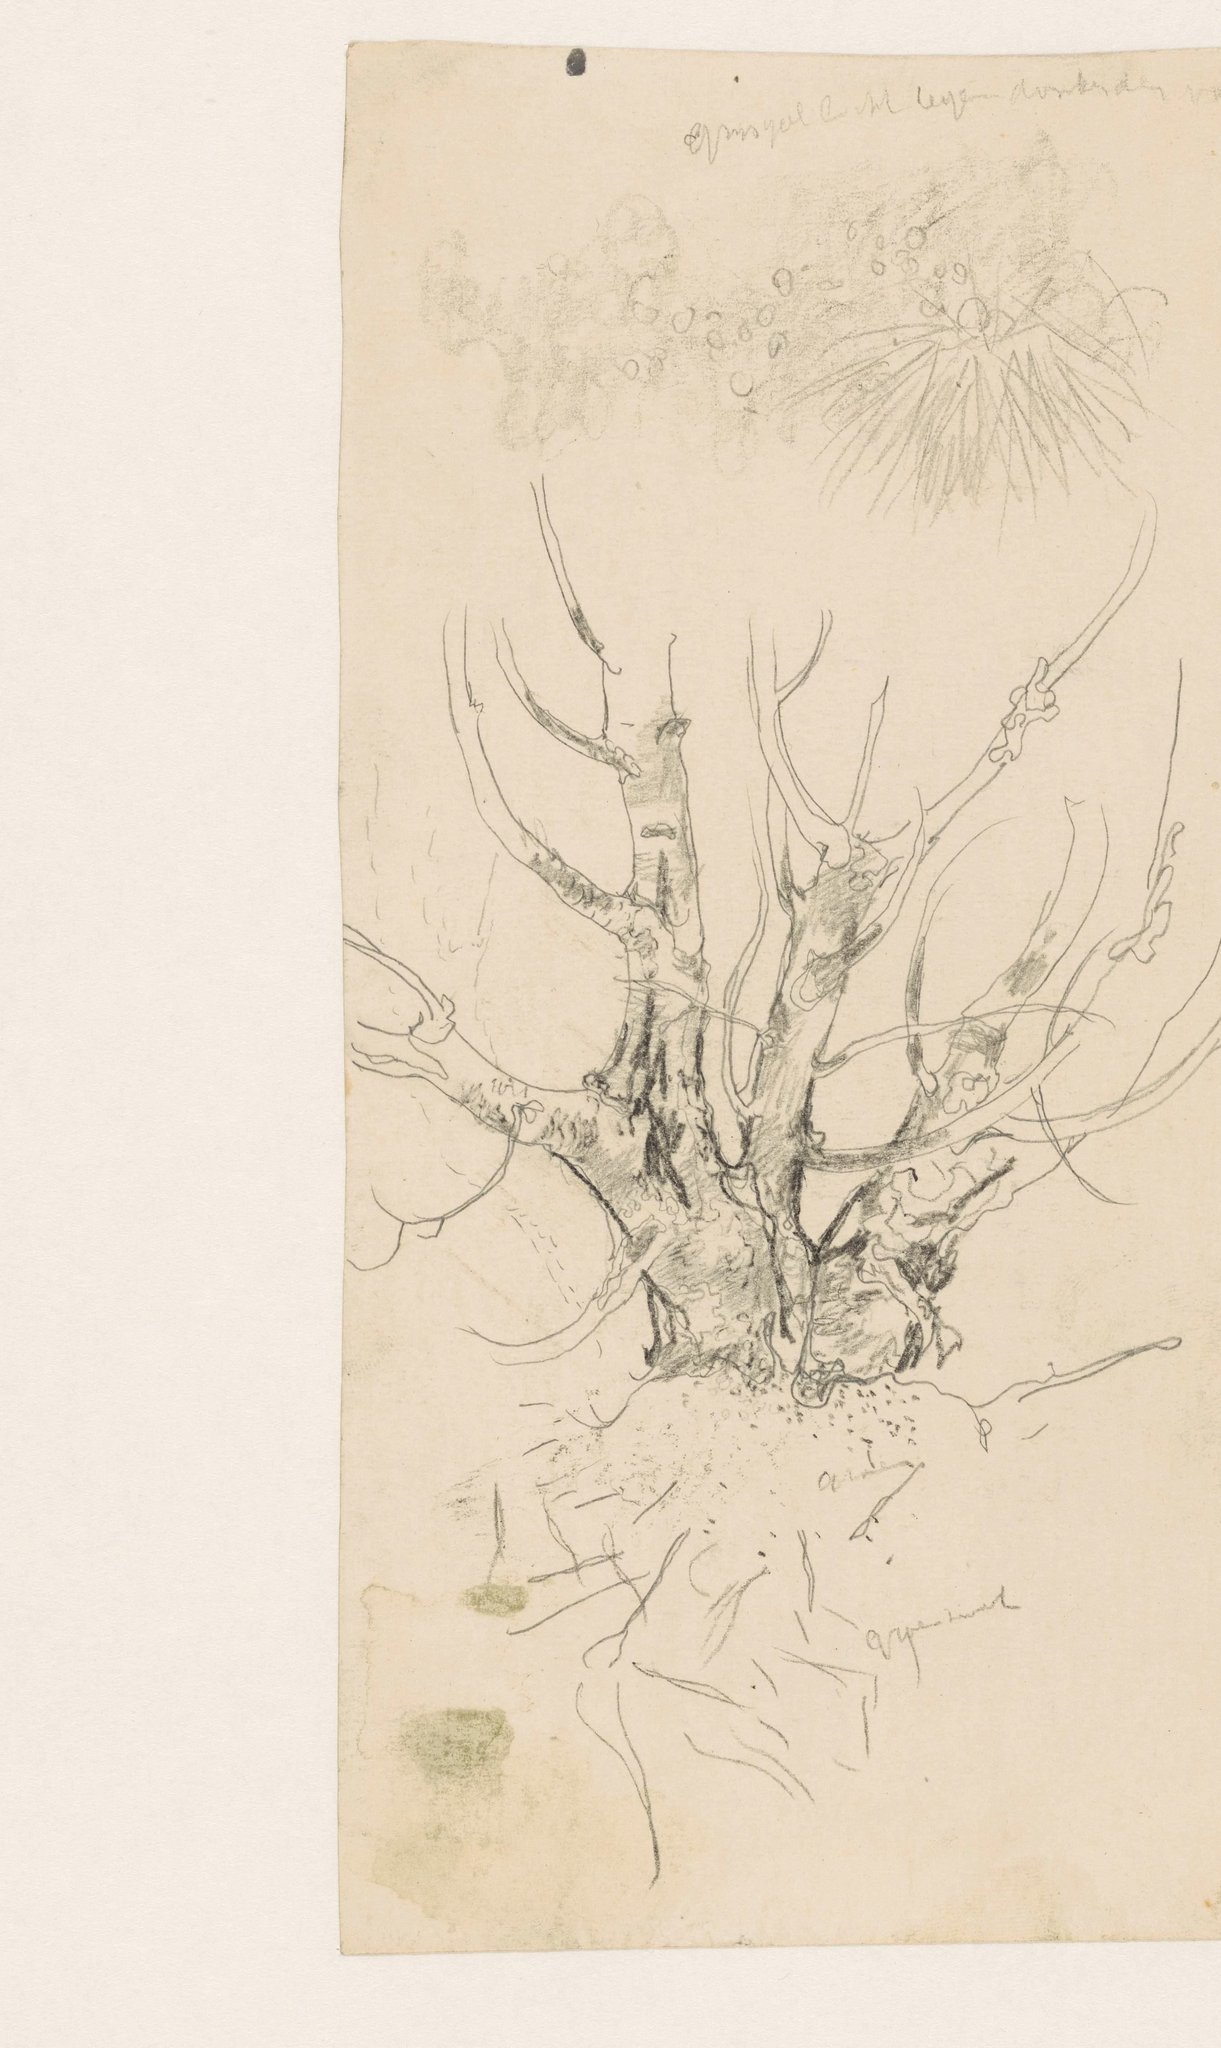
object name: drawing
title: Boomstronk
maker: jan mankes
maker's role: draughtsman, painter, print maker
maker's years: 1889-1920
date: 1899-1920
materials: chalk, paper, pencil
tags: trees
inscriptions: :, collector's mark: Lugt 2228